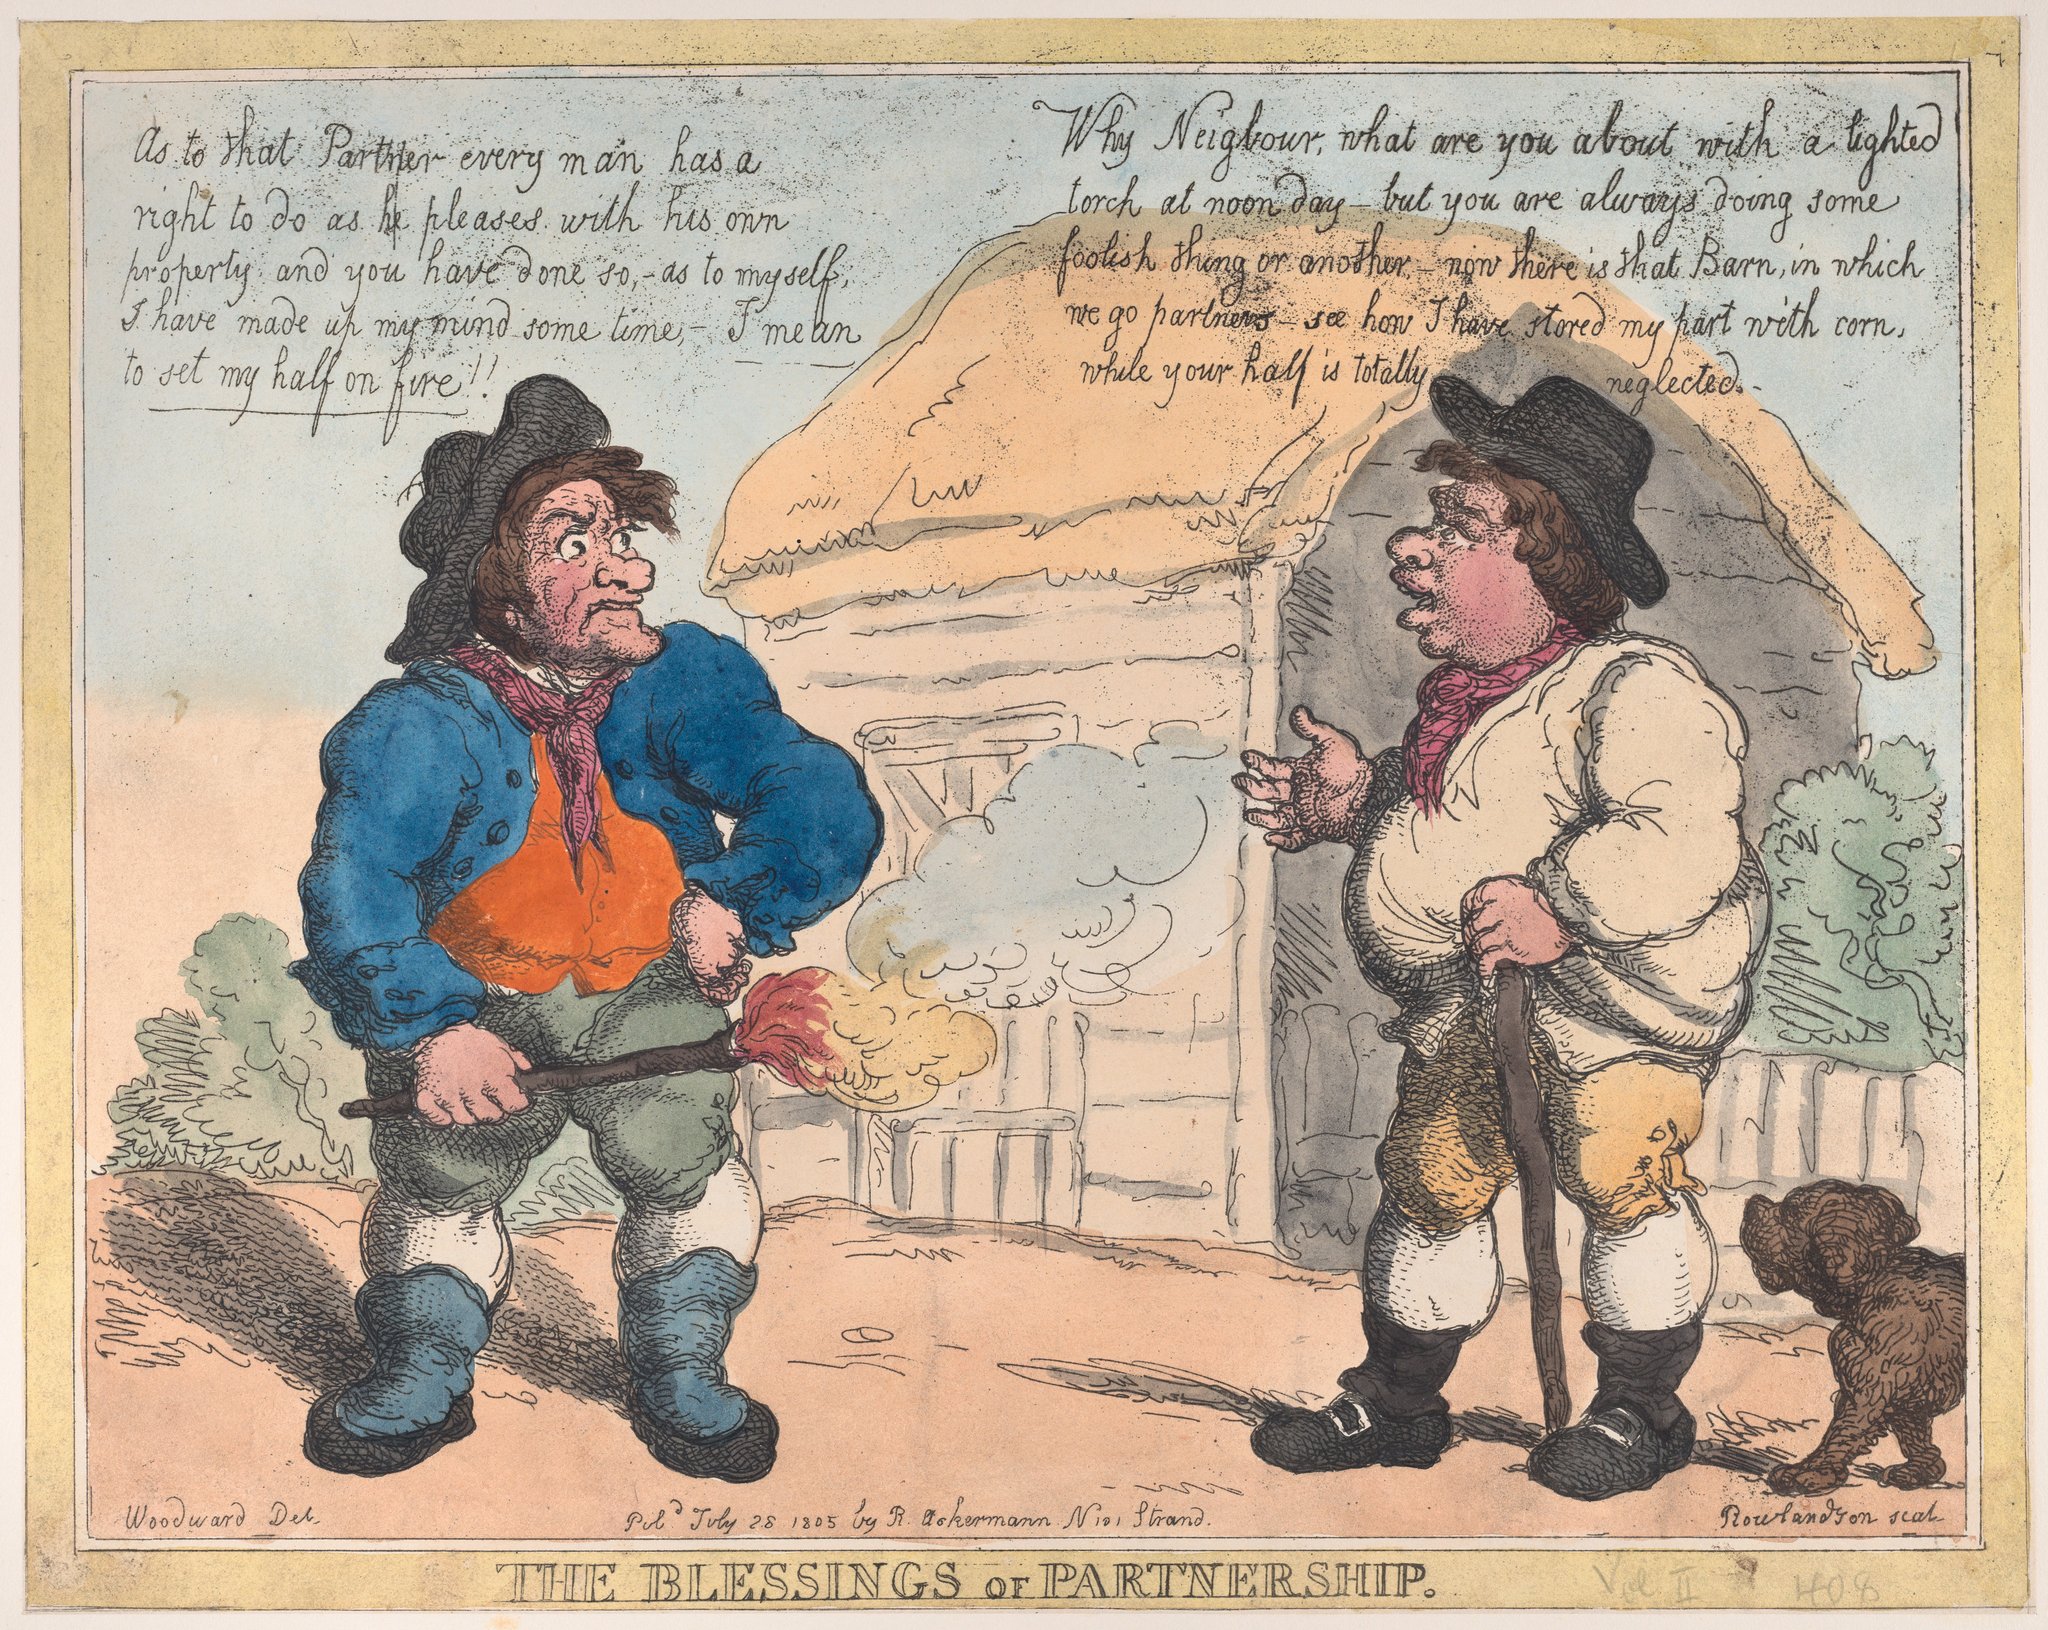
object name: print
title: The Blessings of Partnership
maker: thomas rowlandson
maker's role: artist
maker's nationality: british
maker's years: 1757-1827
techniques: etching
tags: satire,men,dogs